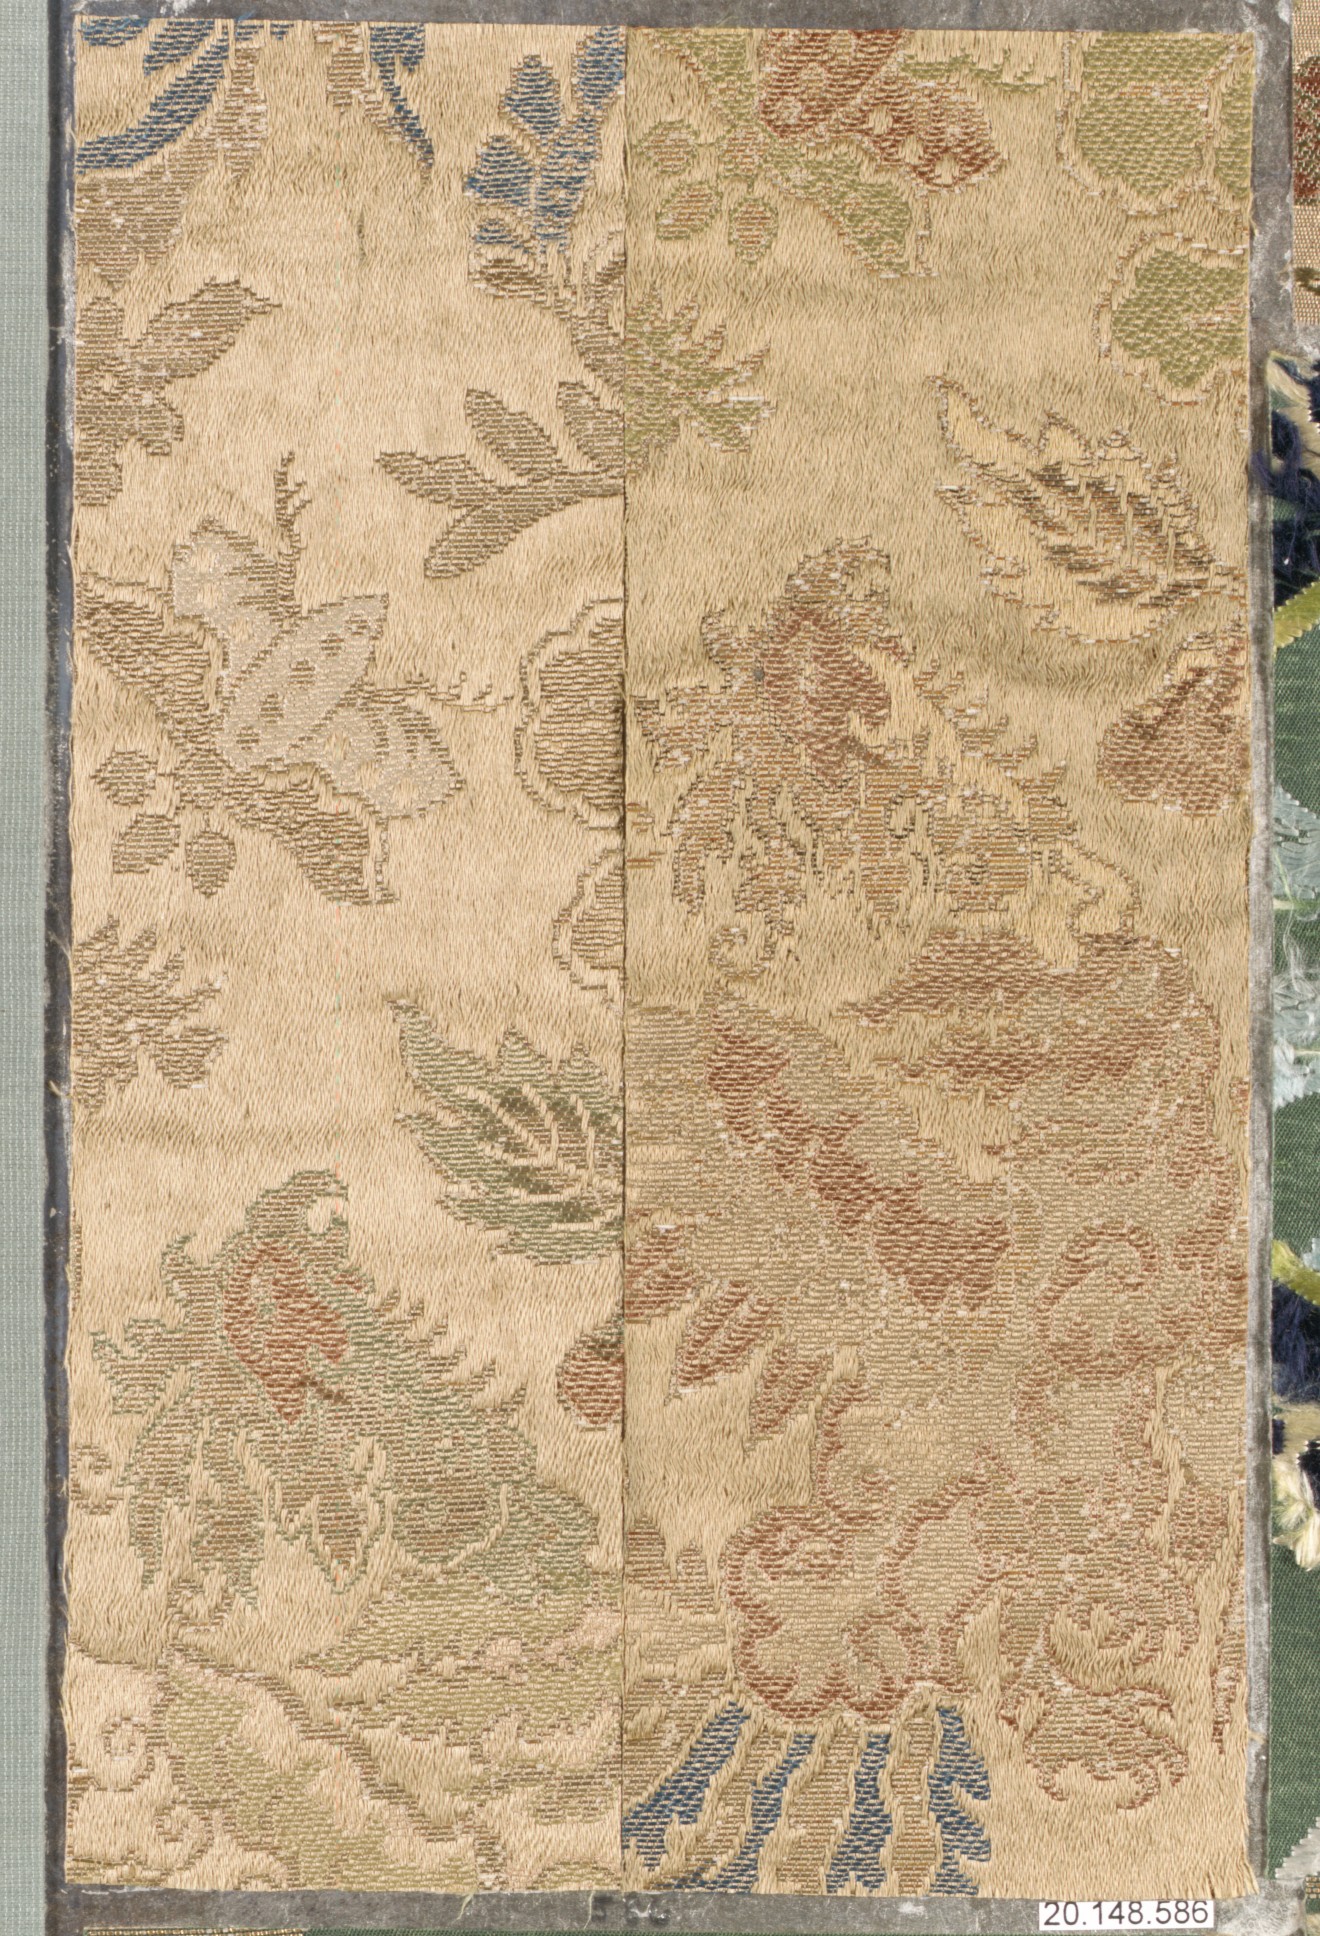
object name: piece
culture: china or japan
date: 1601-1700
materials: silk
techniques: compound weave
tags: leaves